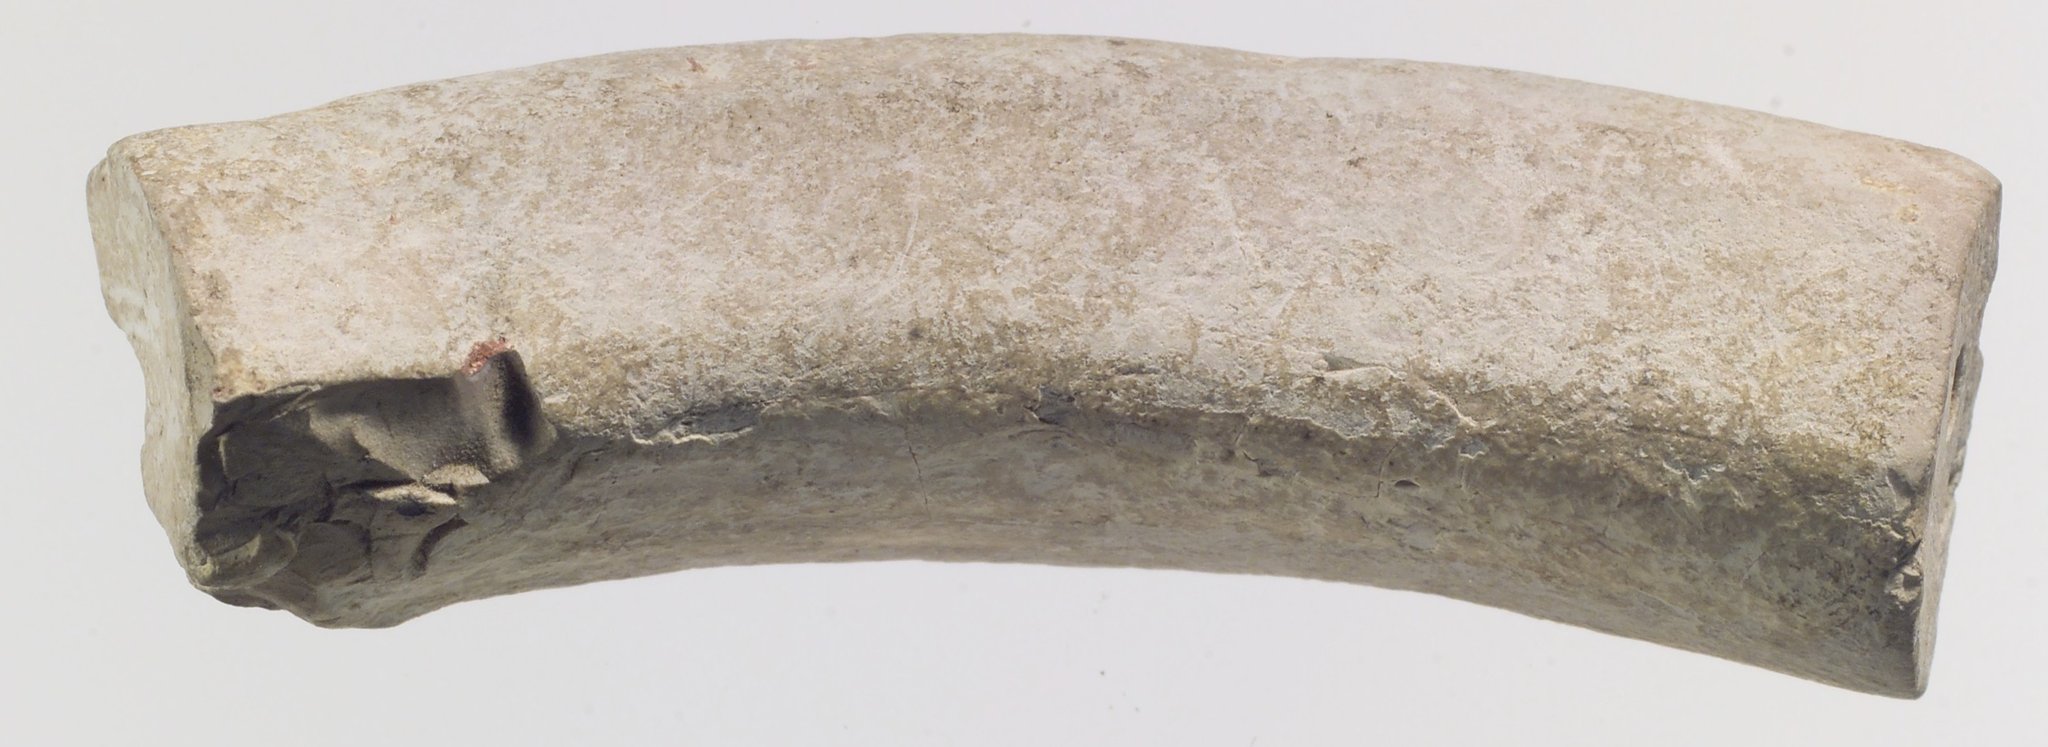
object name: furniture element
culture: assyrian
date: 1800-1701 BCE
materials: ivory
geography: anatolia